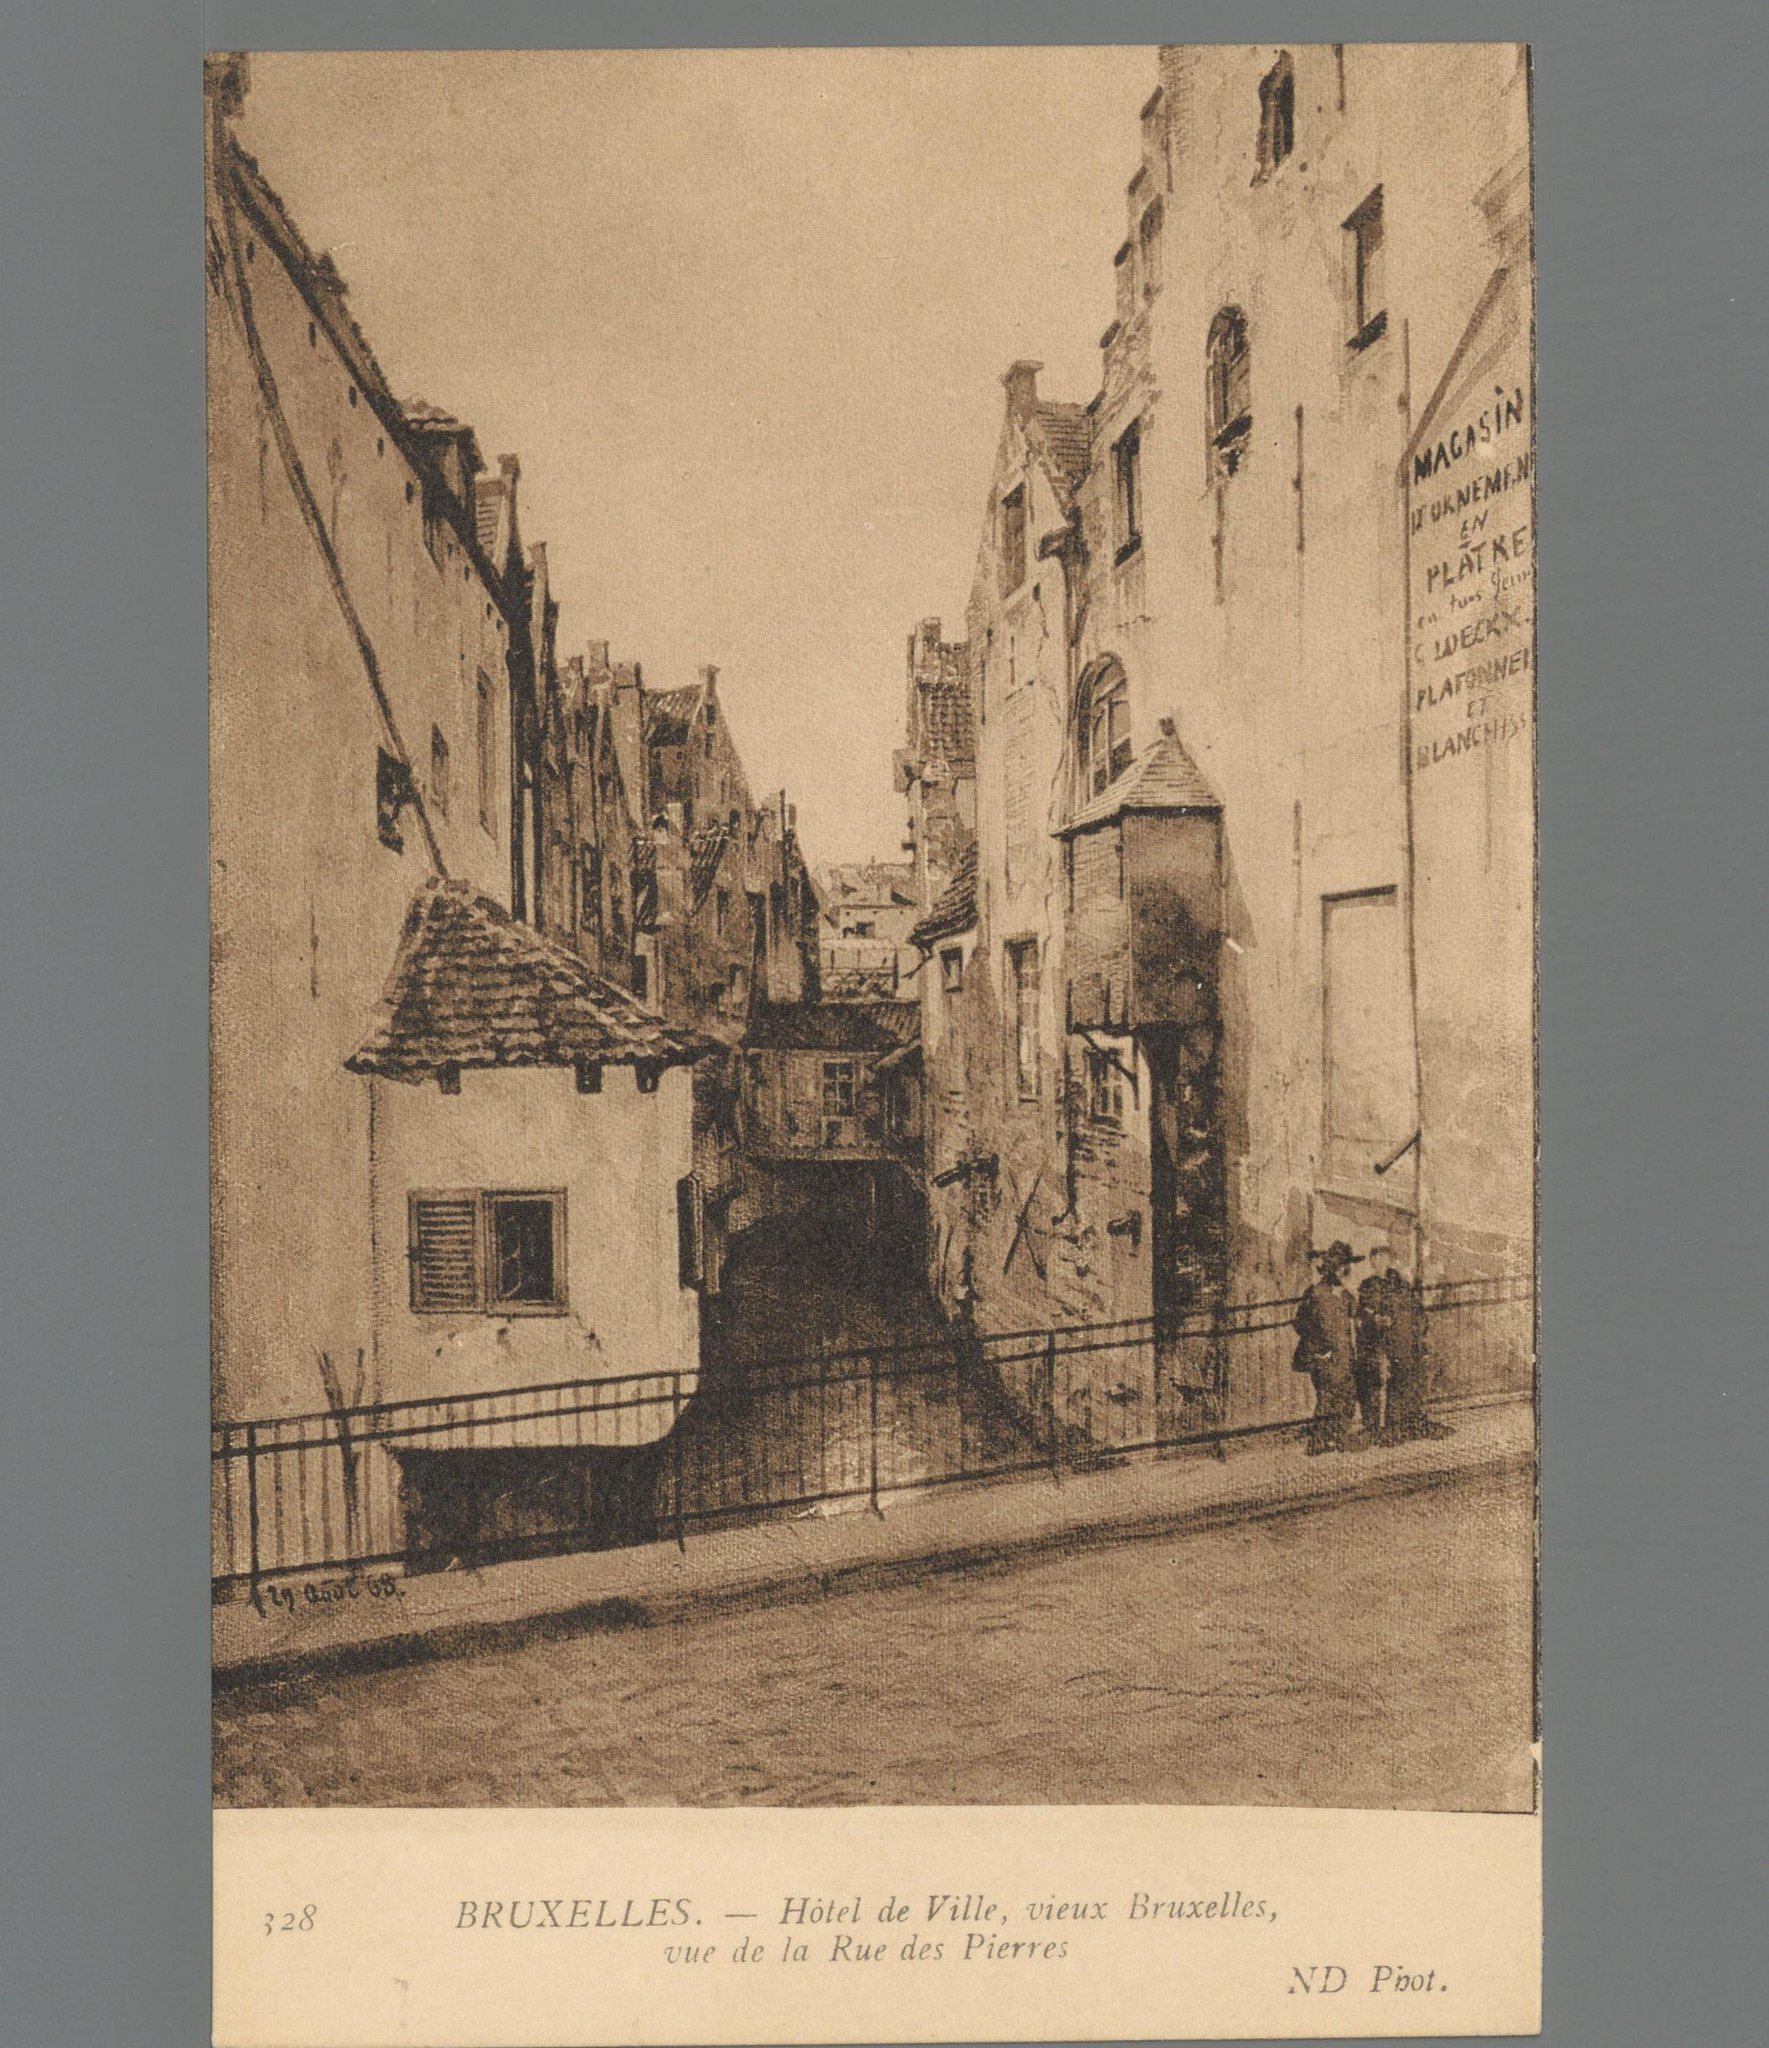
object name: ansichtkaart, prentbriefkaart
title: Bruxelles. Hôtel de Ville, vieux Bruxelles, vue de la Rue des Pierres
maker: Anonymous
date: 1906-1930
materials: cardboard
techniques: photograph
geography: paris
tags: river, city-view, and landscape with man-made constructions (+ city(-scape) with figures, staffage), brussels